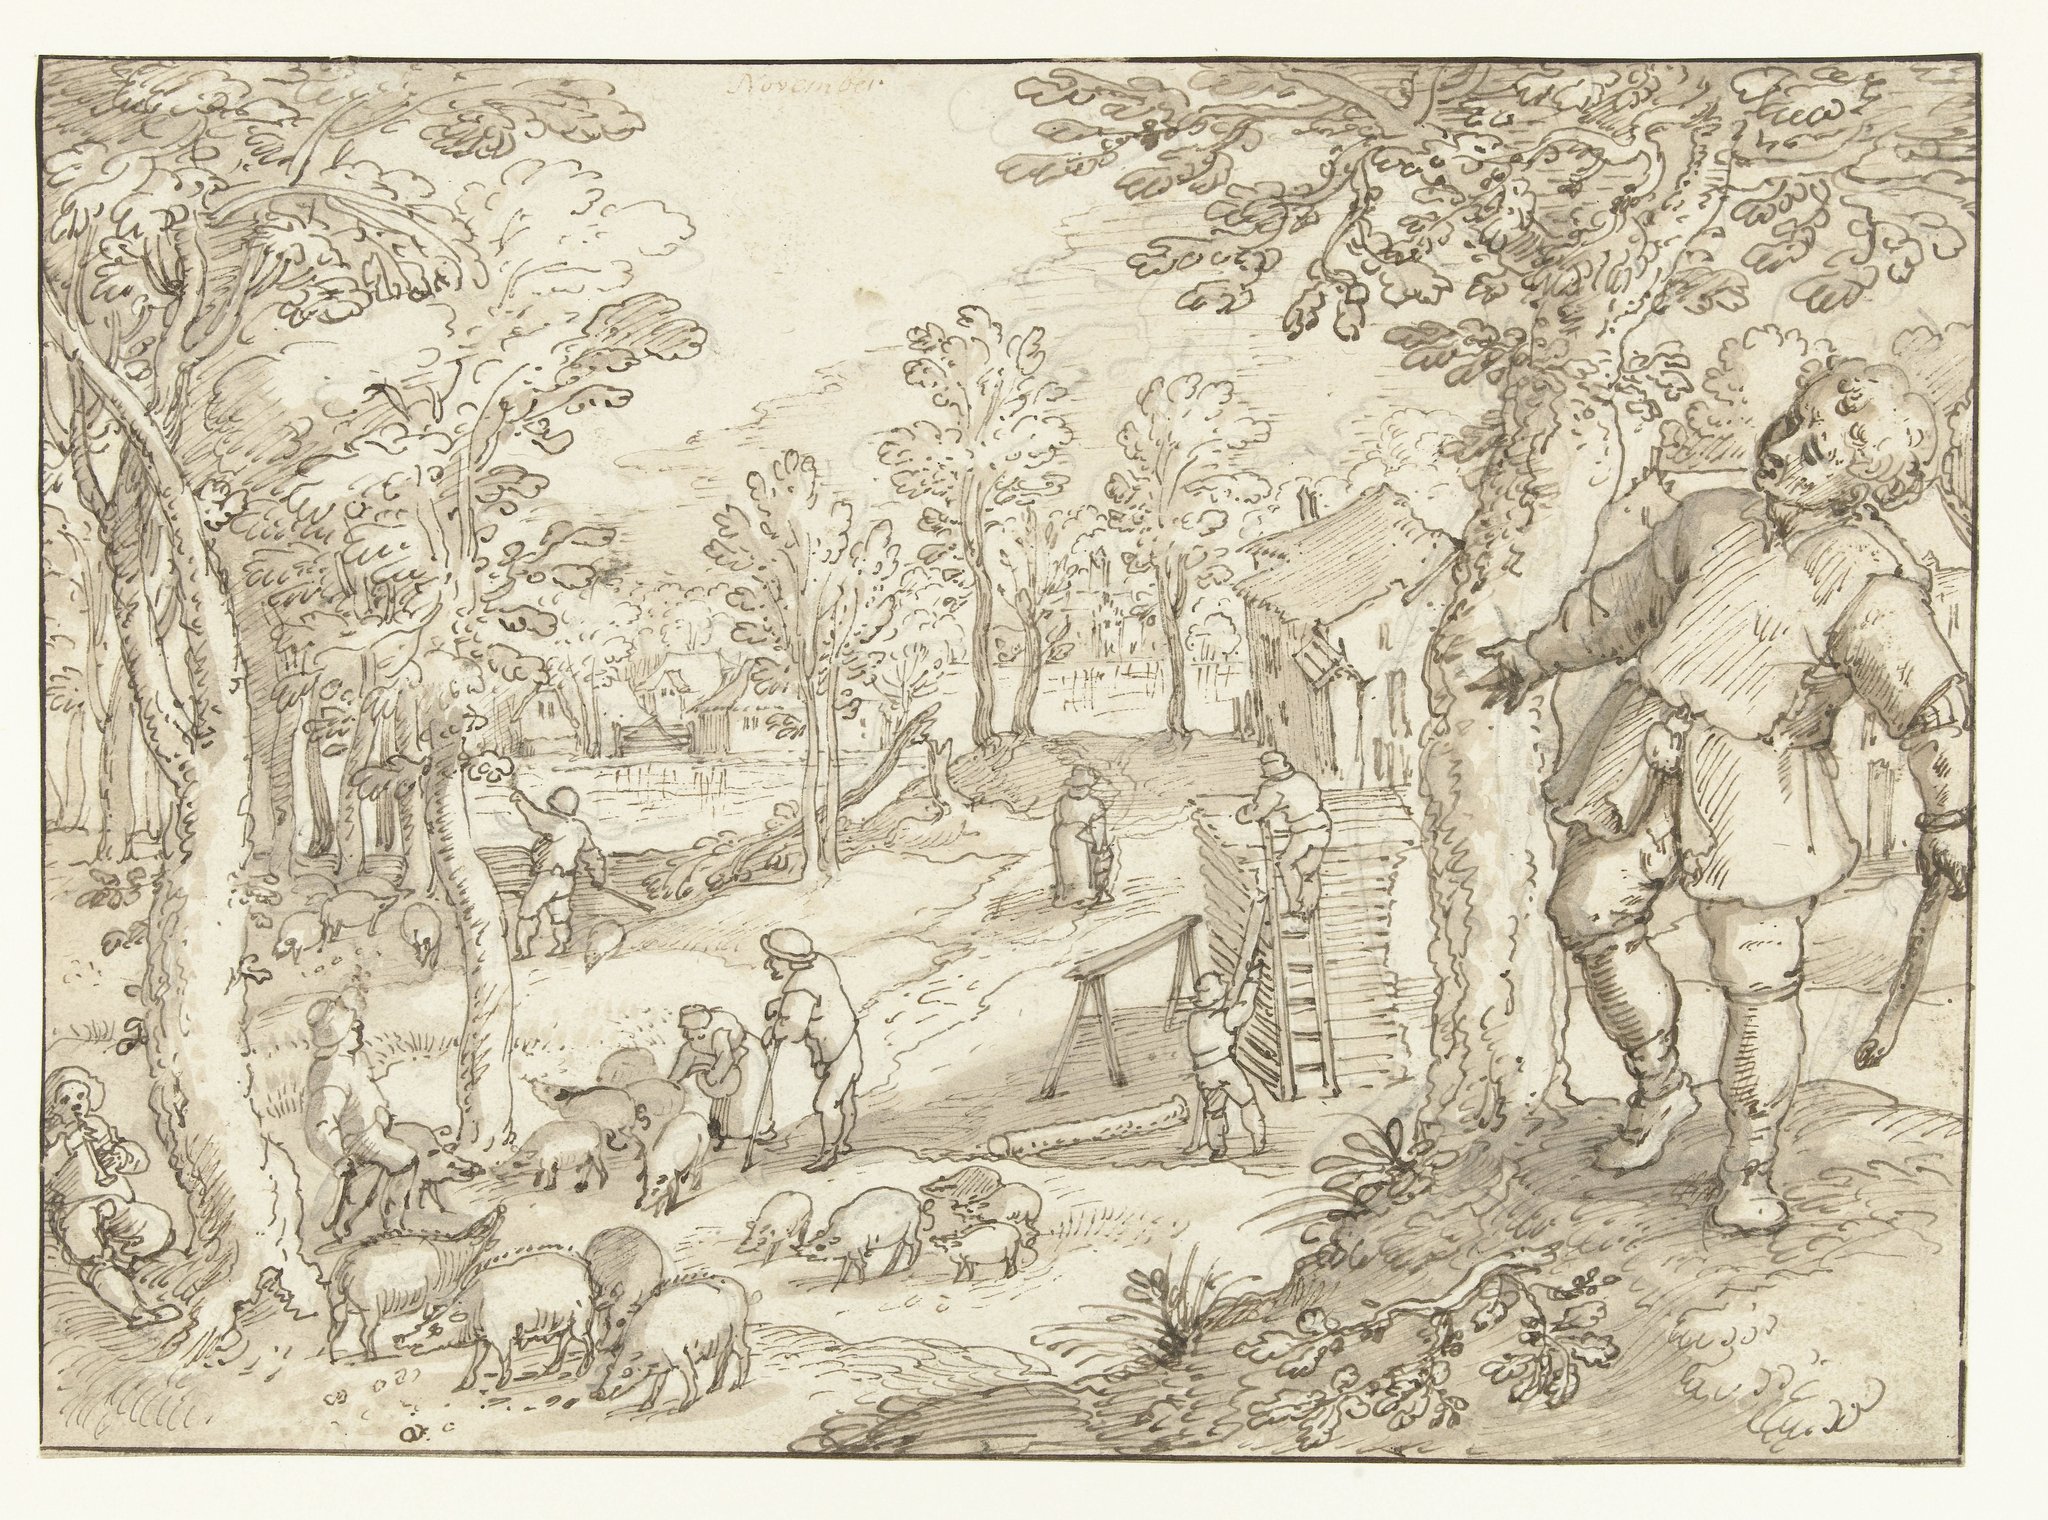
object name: design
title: November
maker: joos de momper (ii)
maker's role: draughtsman, painter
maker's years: 1564-1635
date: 1590-1610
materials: chalk, ink, paper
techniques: brush, pen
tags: november and its 'labours', driving pigs to the wood to eat acorns, fruits: acorn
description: De maand november. Man met stok om eikels uit de boom te slaan, links een kudde vakens en een zwijnenhoeder. Ontwerp voor een prent.